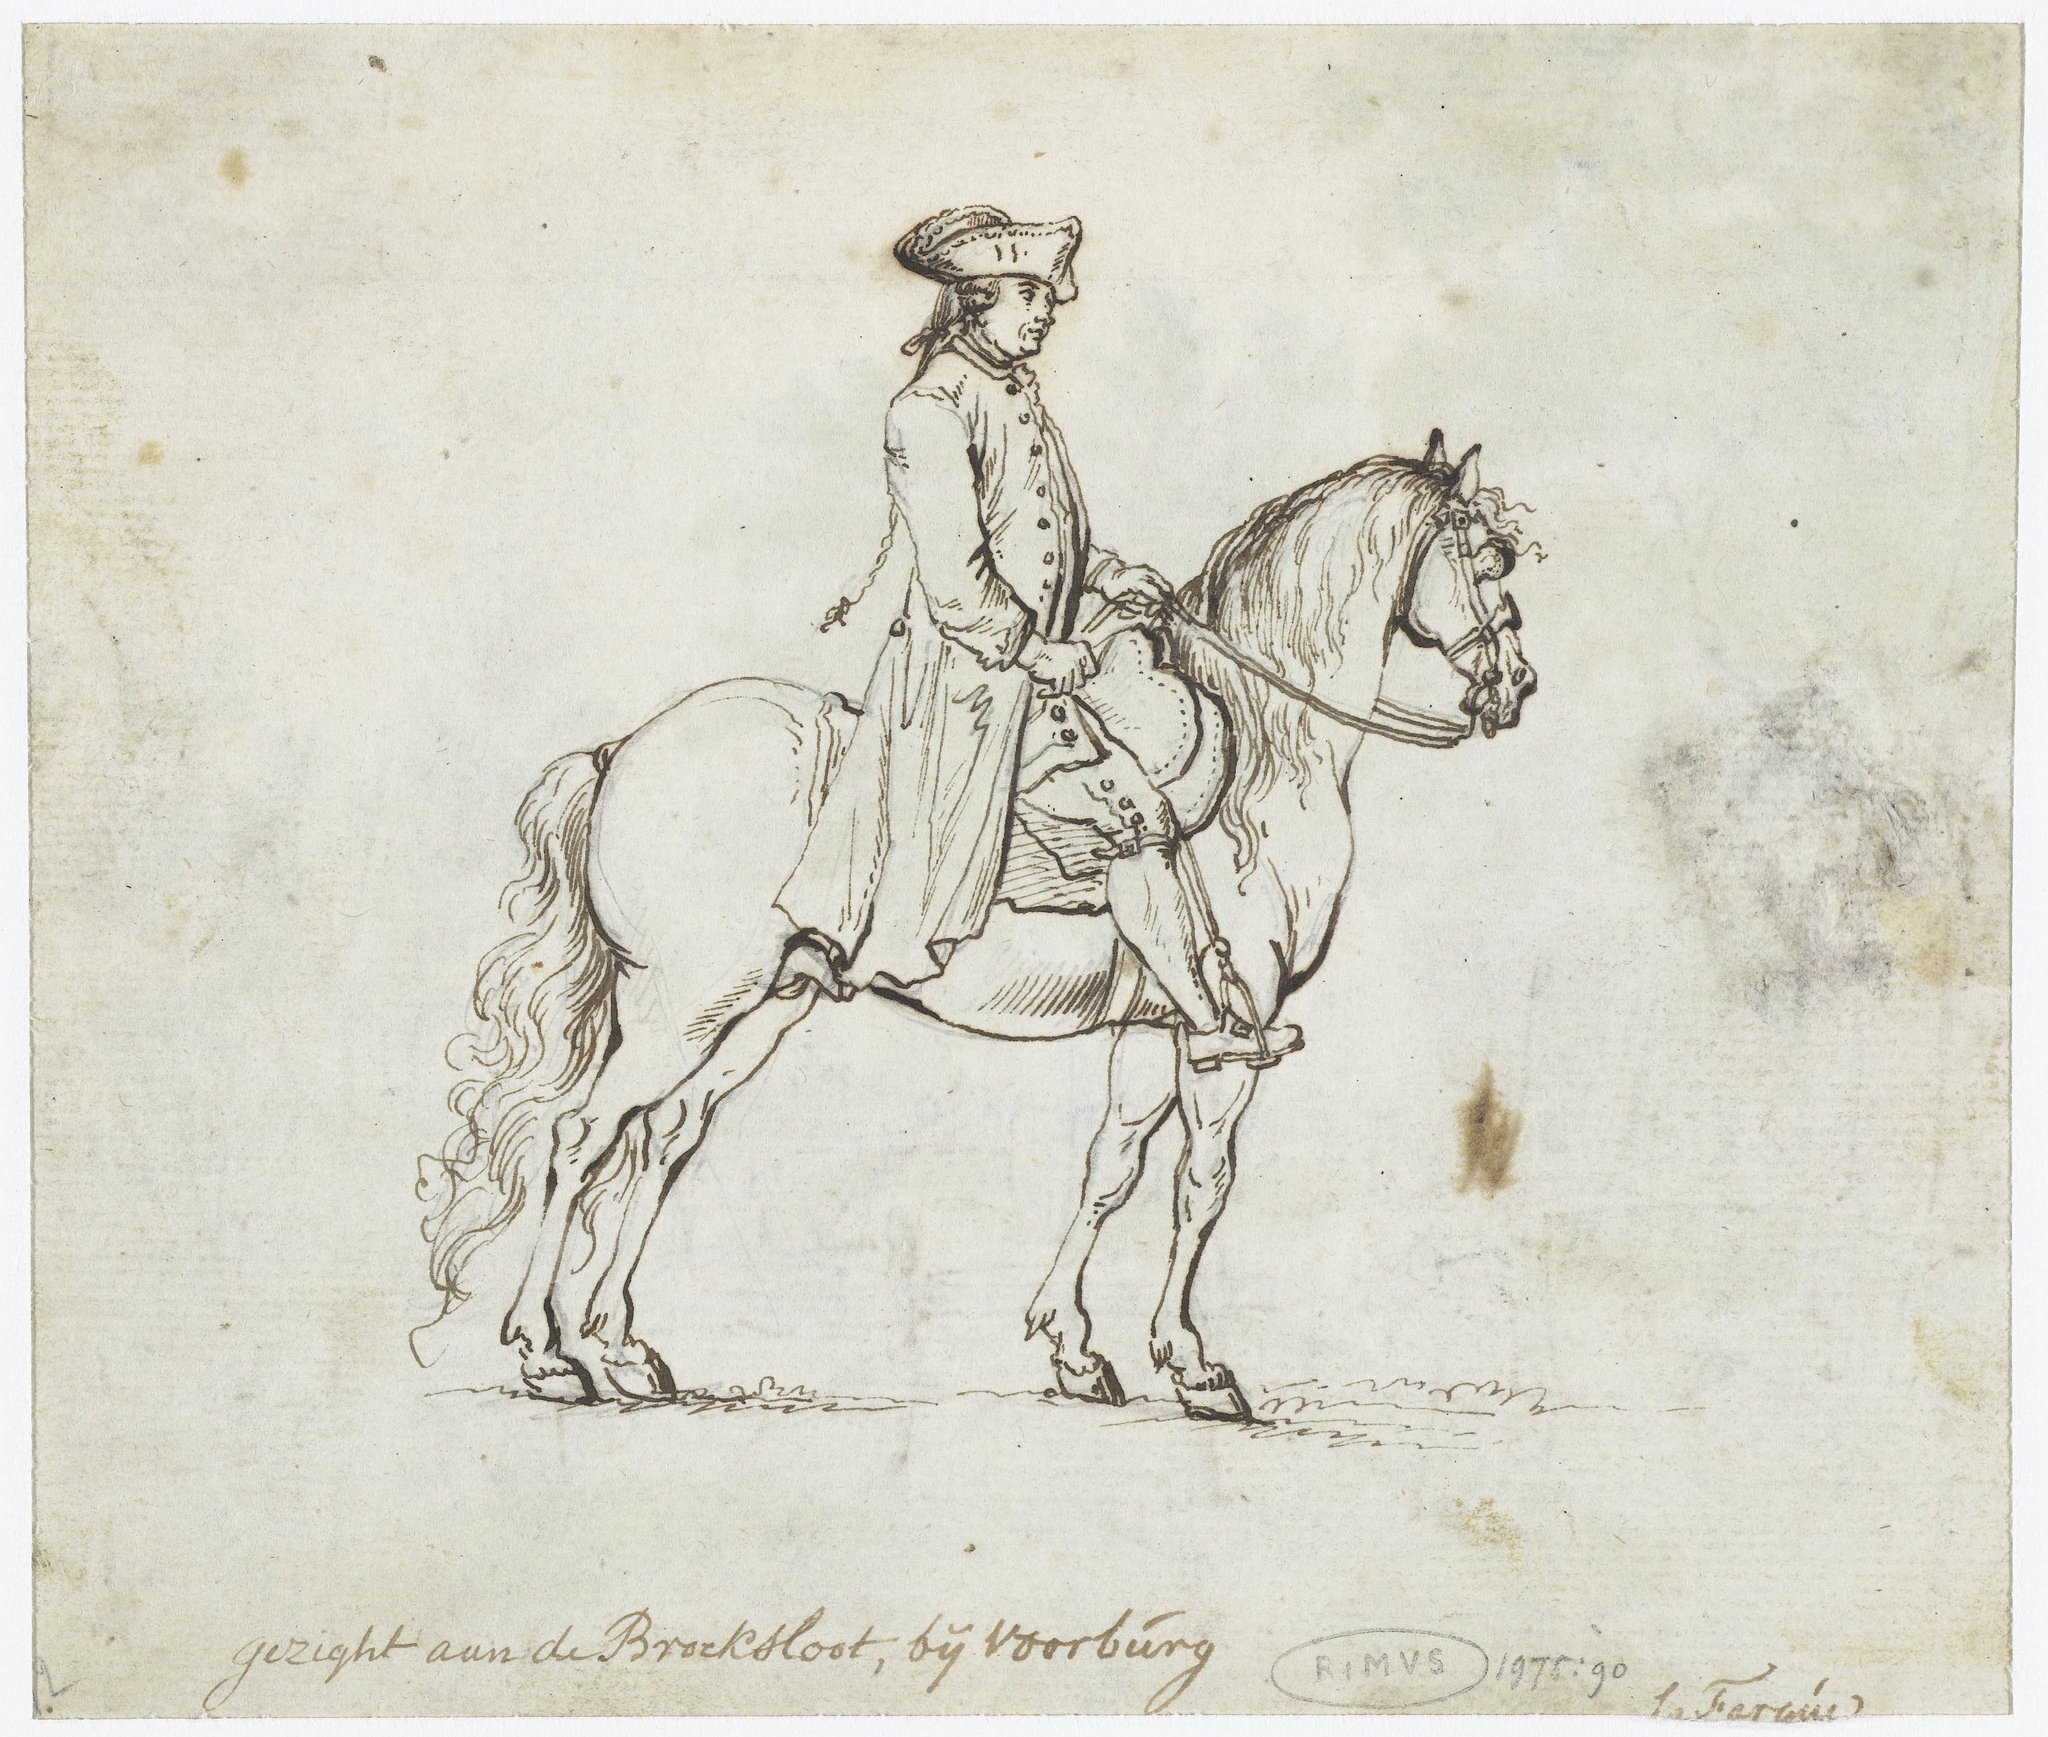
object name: drawing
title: Officier te paard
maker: paulus constantijn la fargue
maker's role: draughtsman, painter, print maker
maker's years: 1729-1782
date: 1739-1782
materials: ink, paper, pencil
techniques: pen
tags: land forces (+ cavalry, horsemen), officer